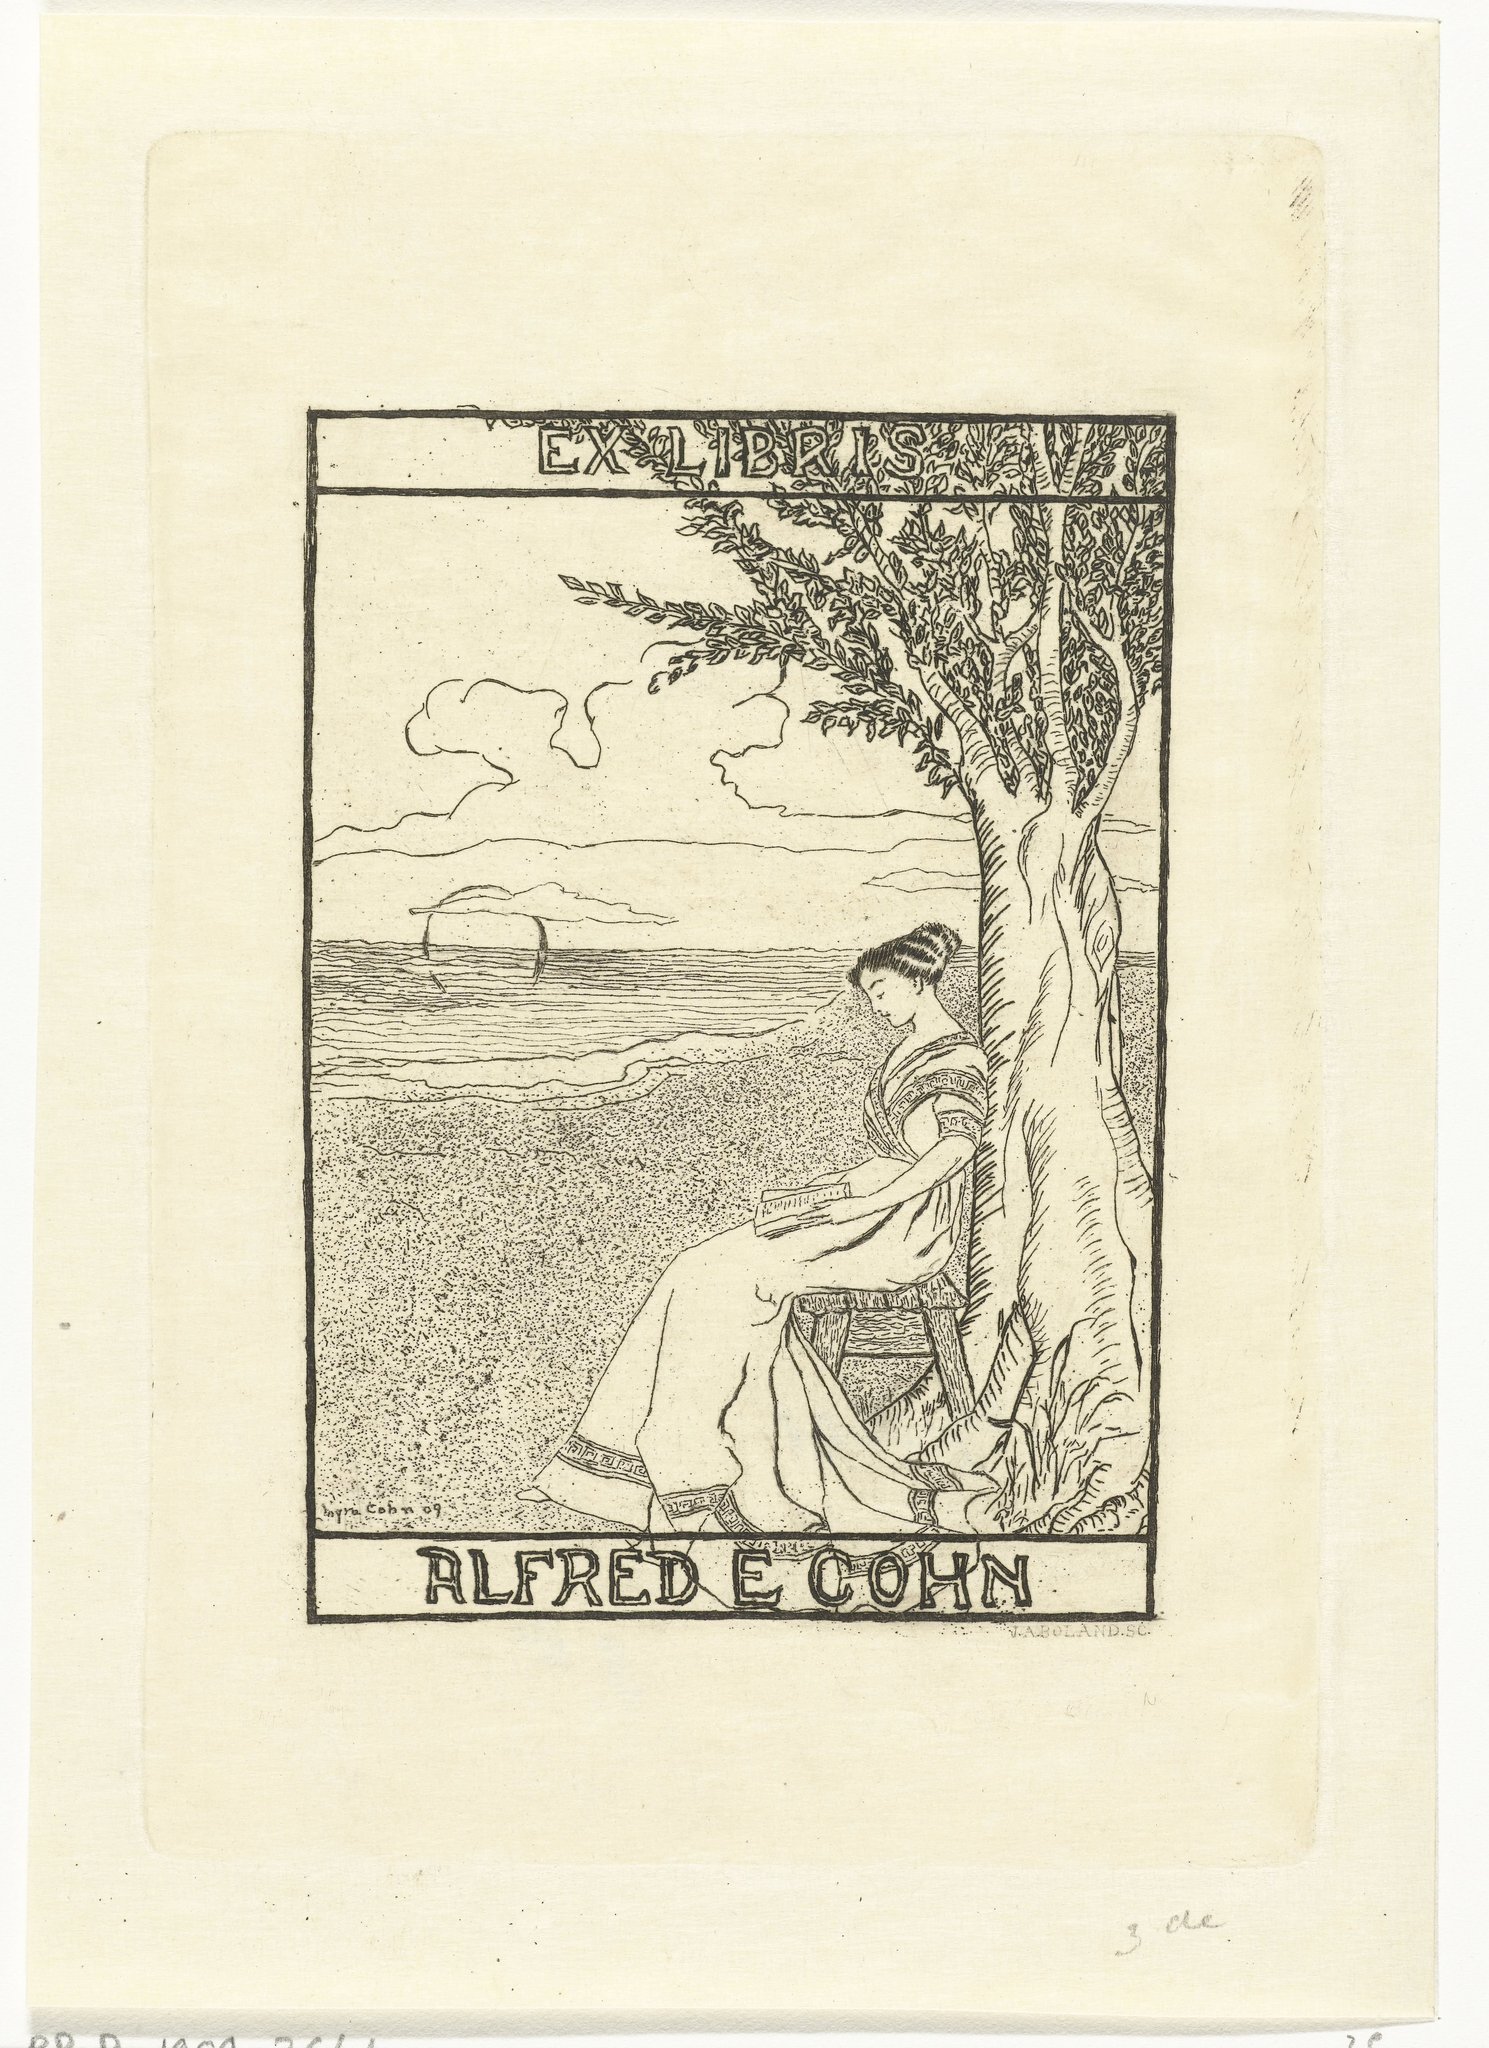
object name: bookplate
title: Ex libris van Alfred E. Cohn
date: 1909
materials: paper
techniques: etching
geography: amsterdam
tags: reading, ex-libris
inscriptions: collector's mark: Lugt 2228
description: Een jonge vrouw zit lezend onder een boom. De zon gaat net onder in de zee.